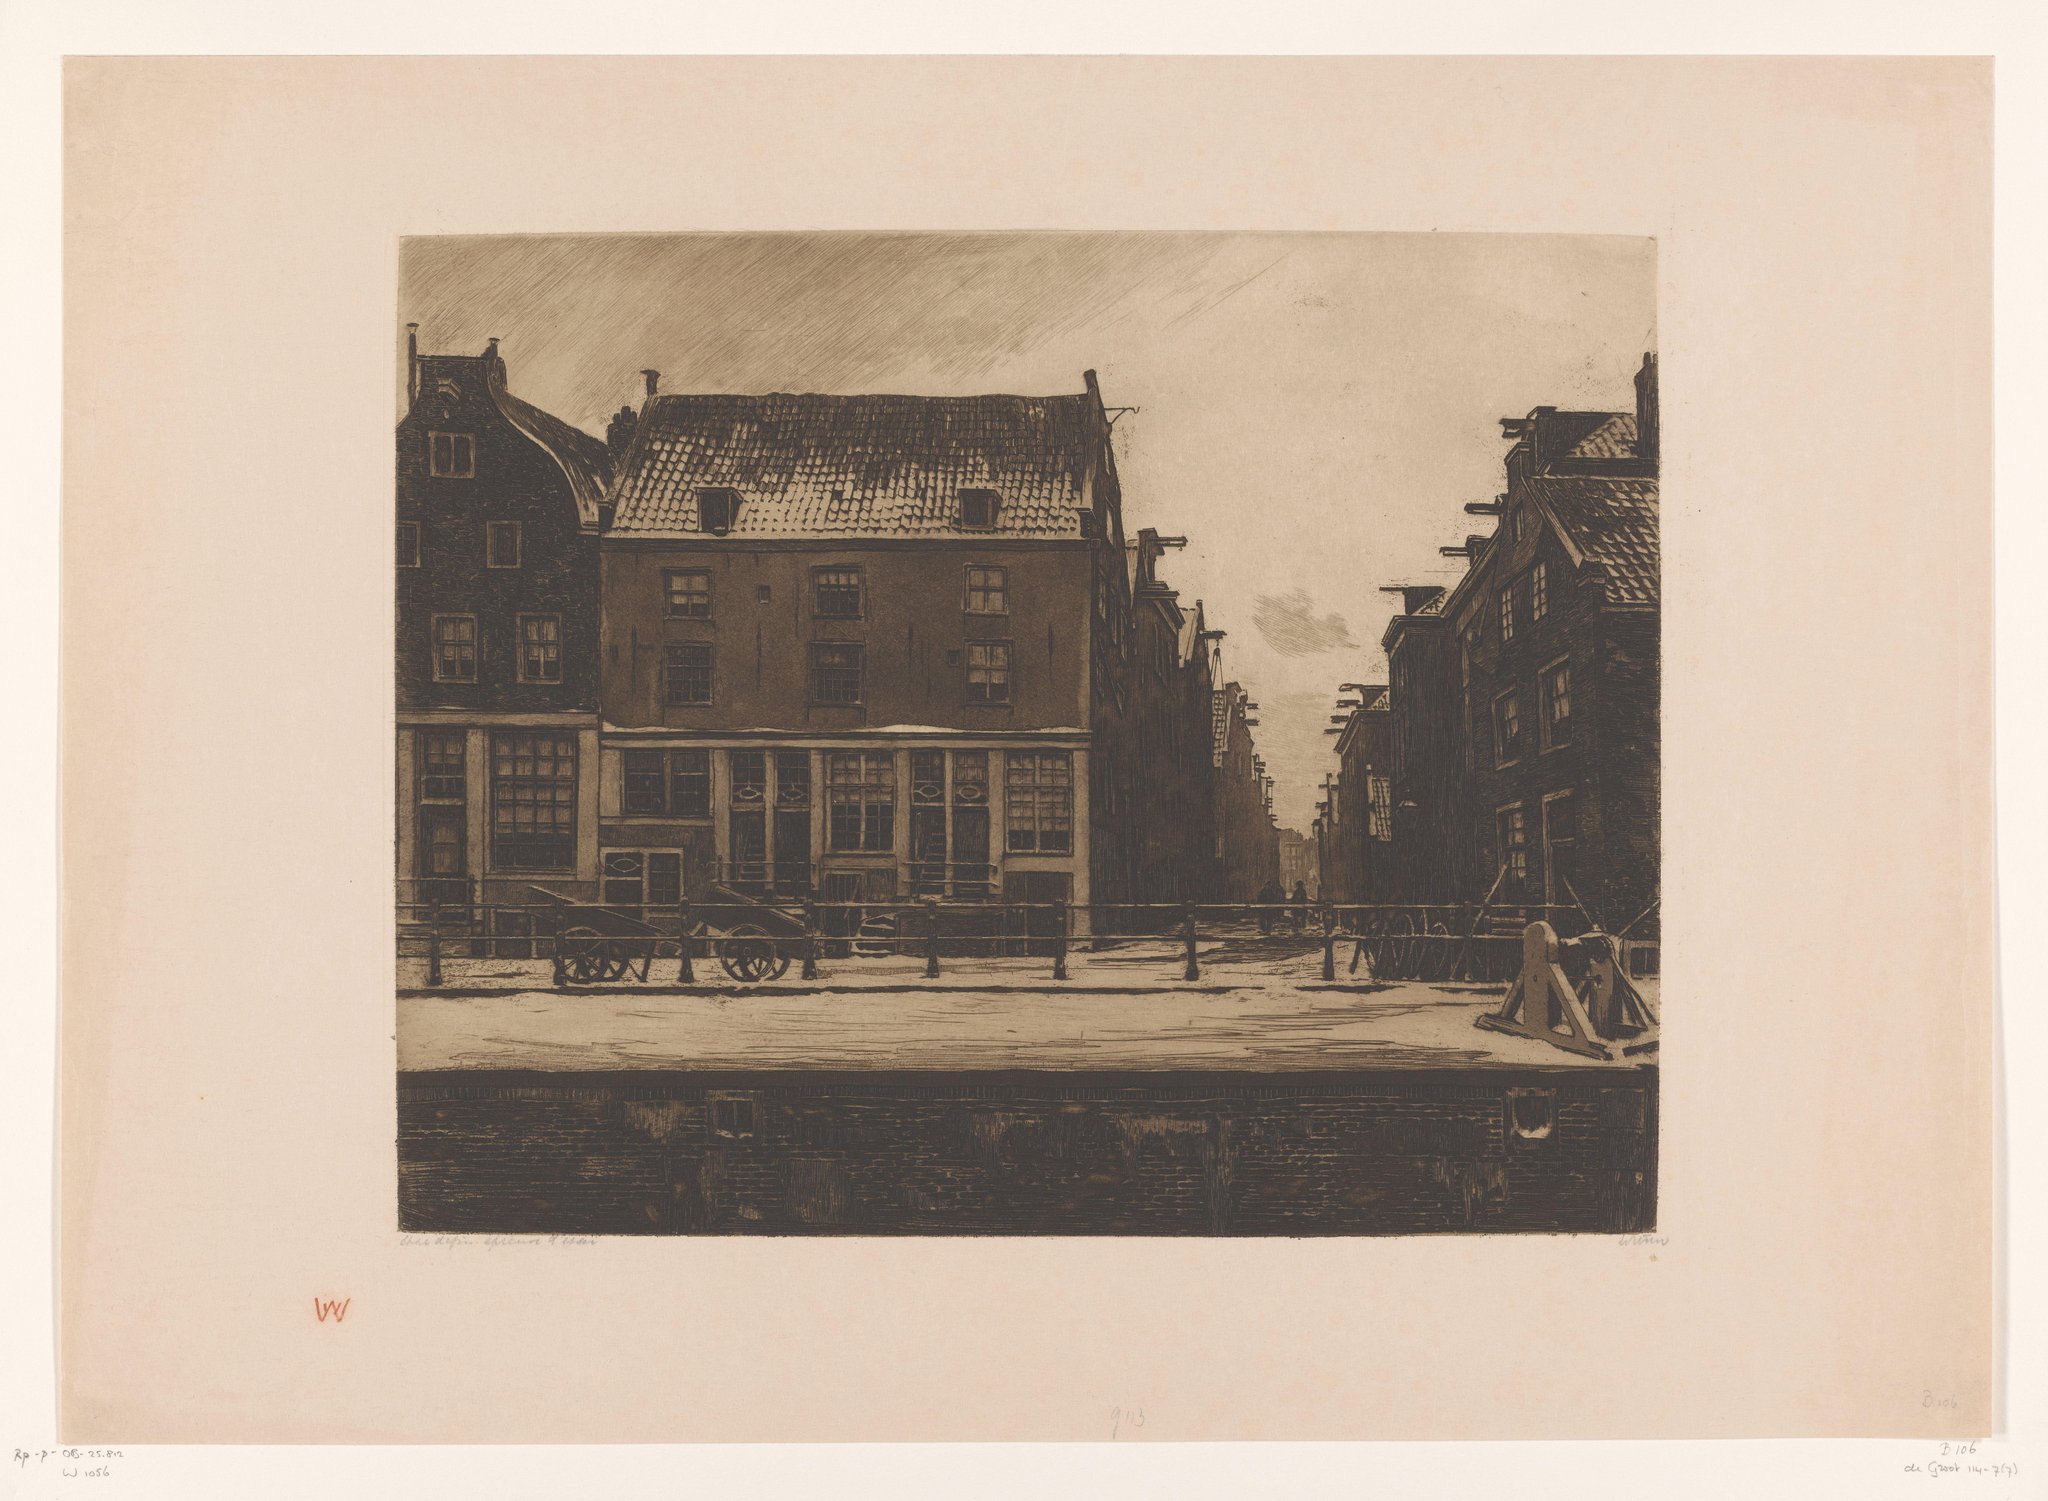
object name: print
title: Jodenhouttuinen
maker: willem witsen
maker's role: draughtsman, painter, print maker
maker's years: 1860-1923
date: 1905-1906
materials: paper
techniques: aquatint, etching, intaglio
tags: urban housing, street, amsterdam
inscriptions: annotation: ‘état defin. épreuve d'essai’